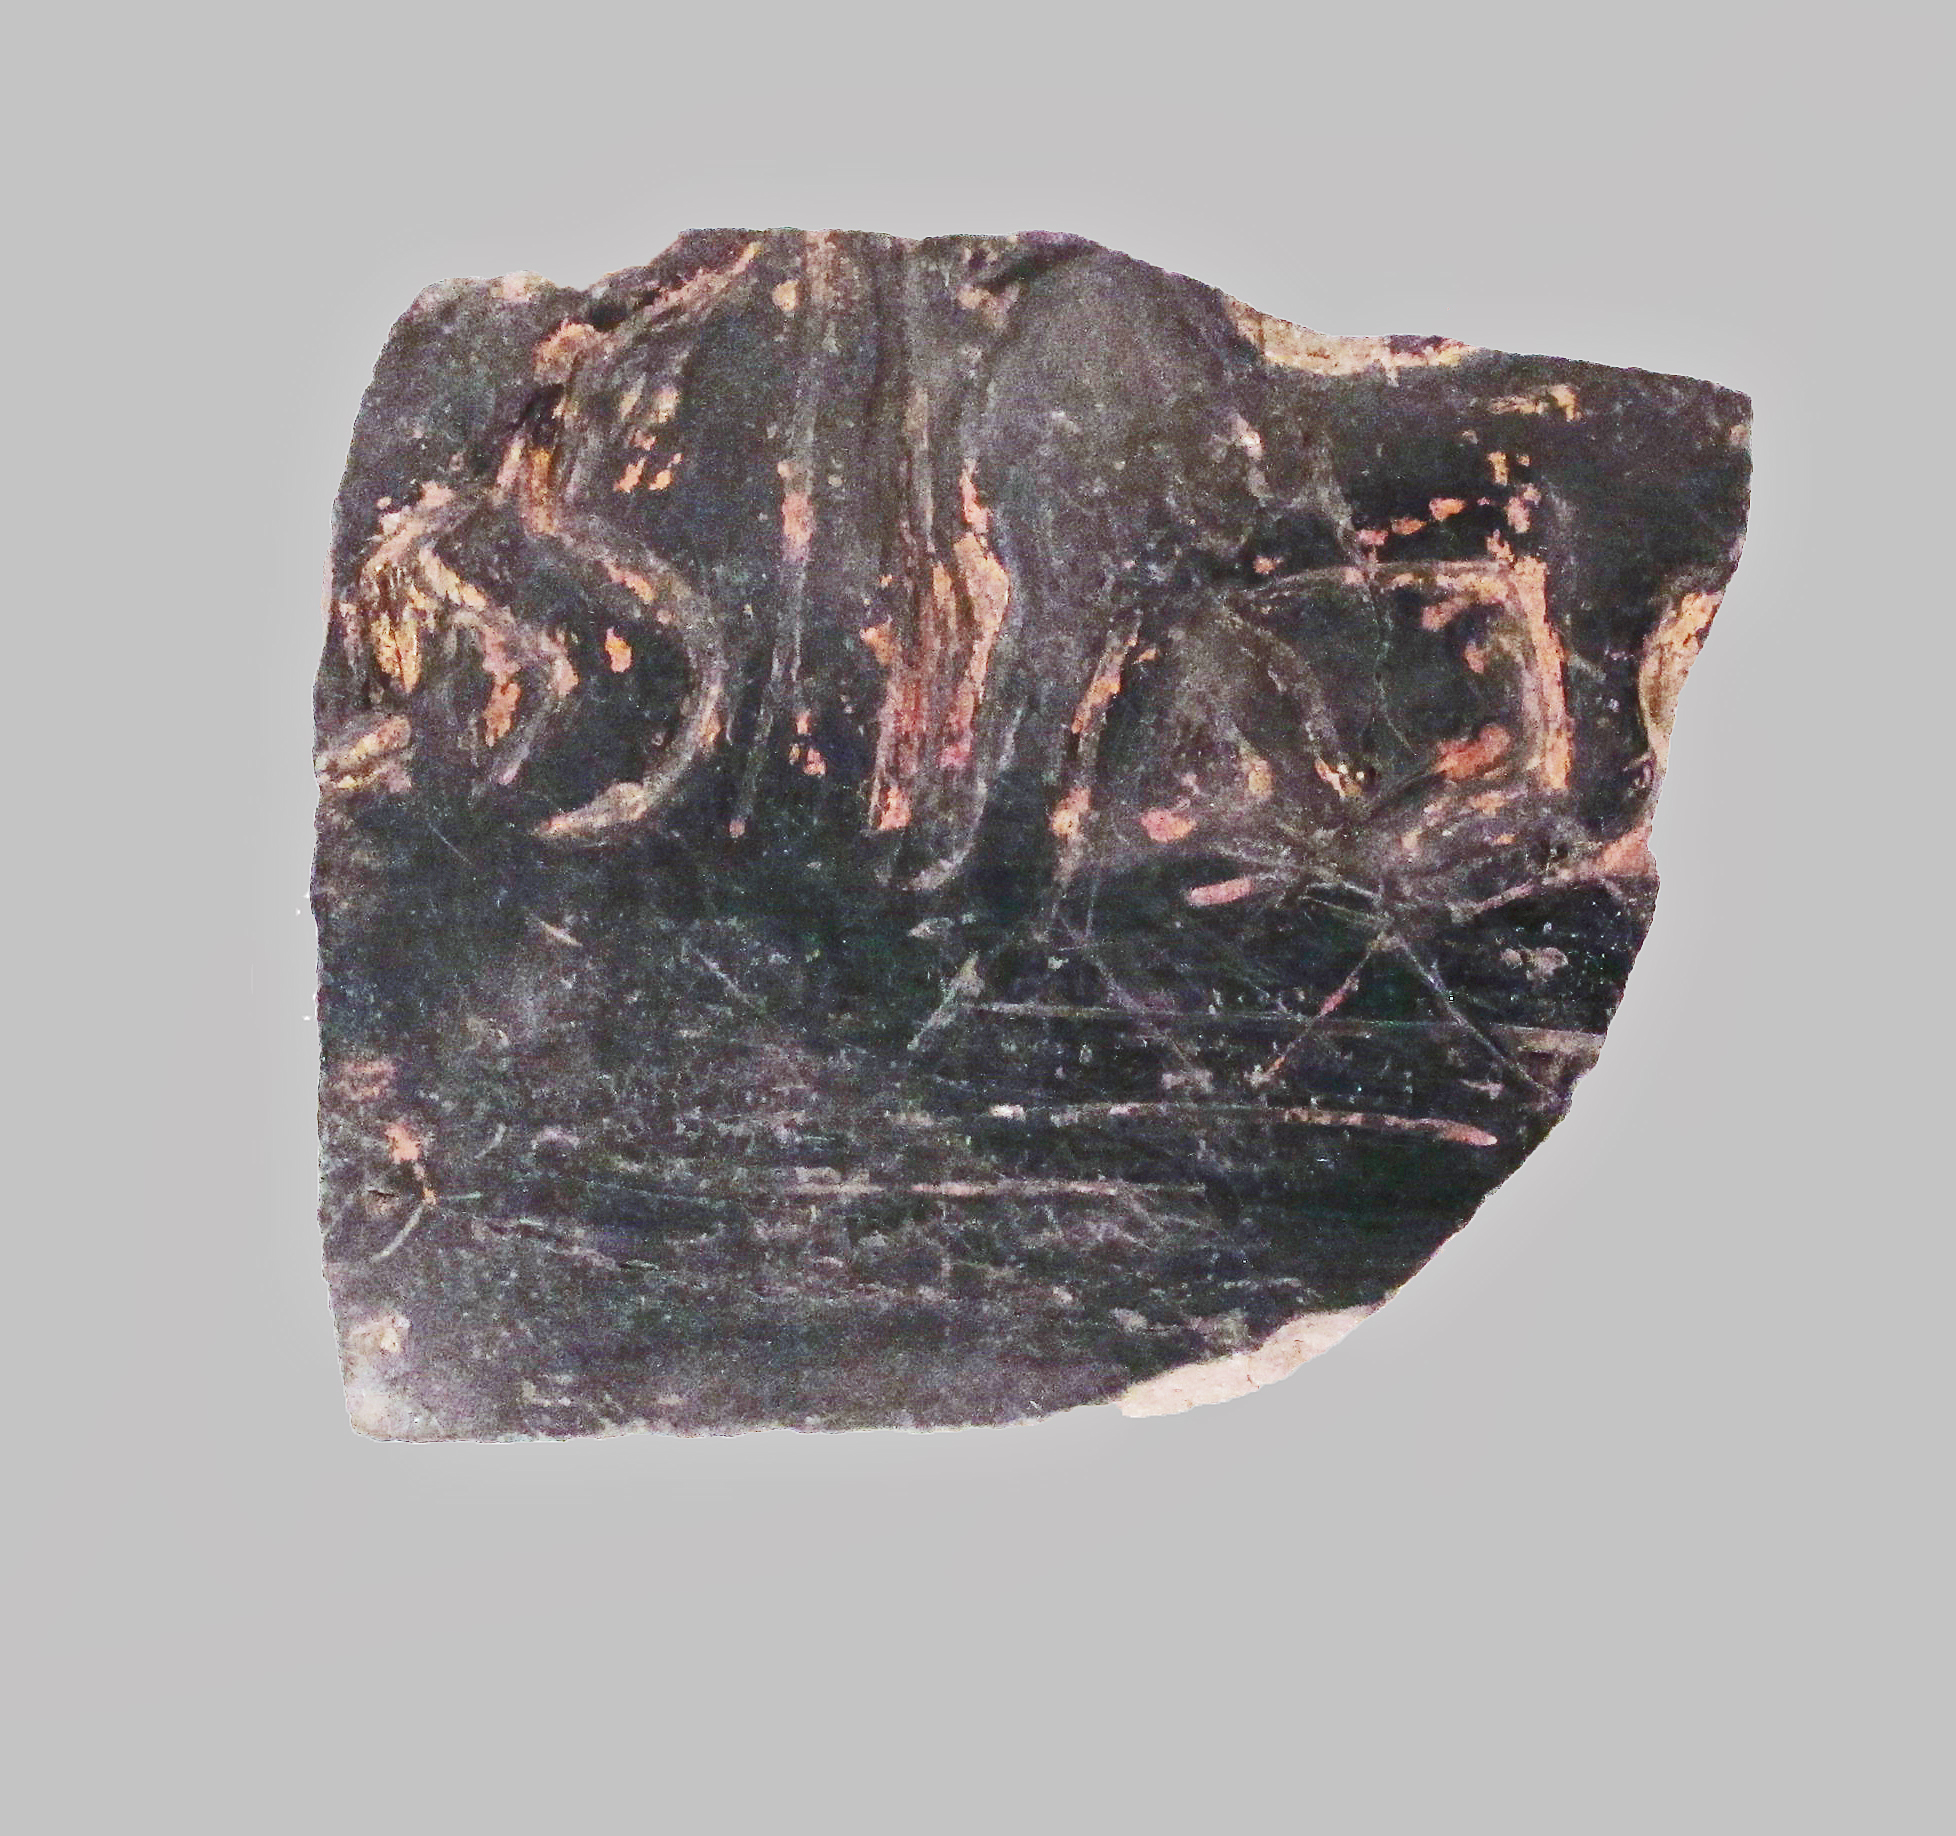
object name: vase fragment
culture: etruscan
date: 575-550 BCE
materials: terracotta